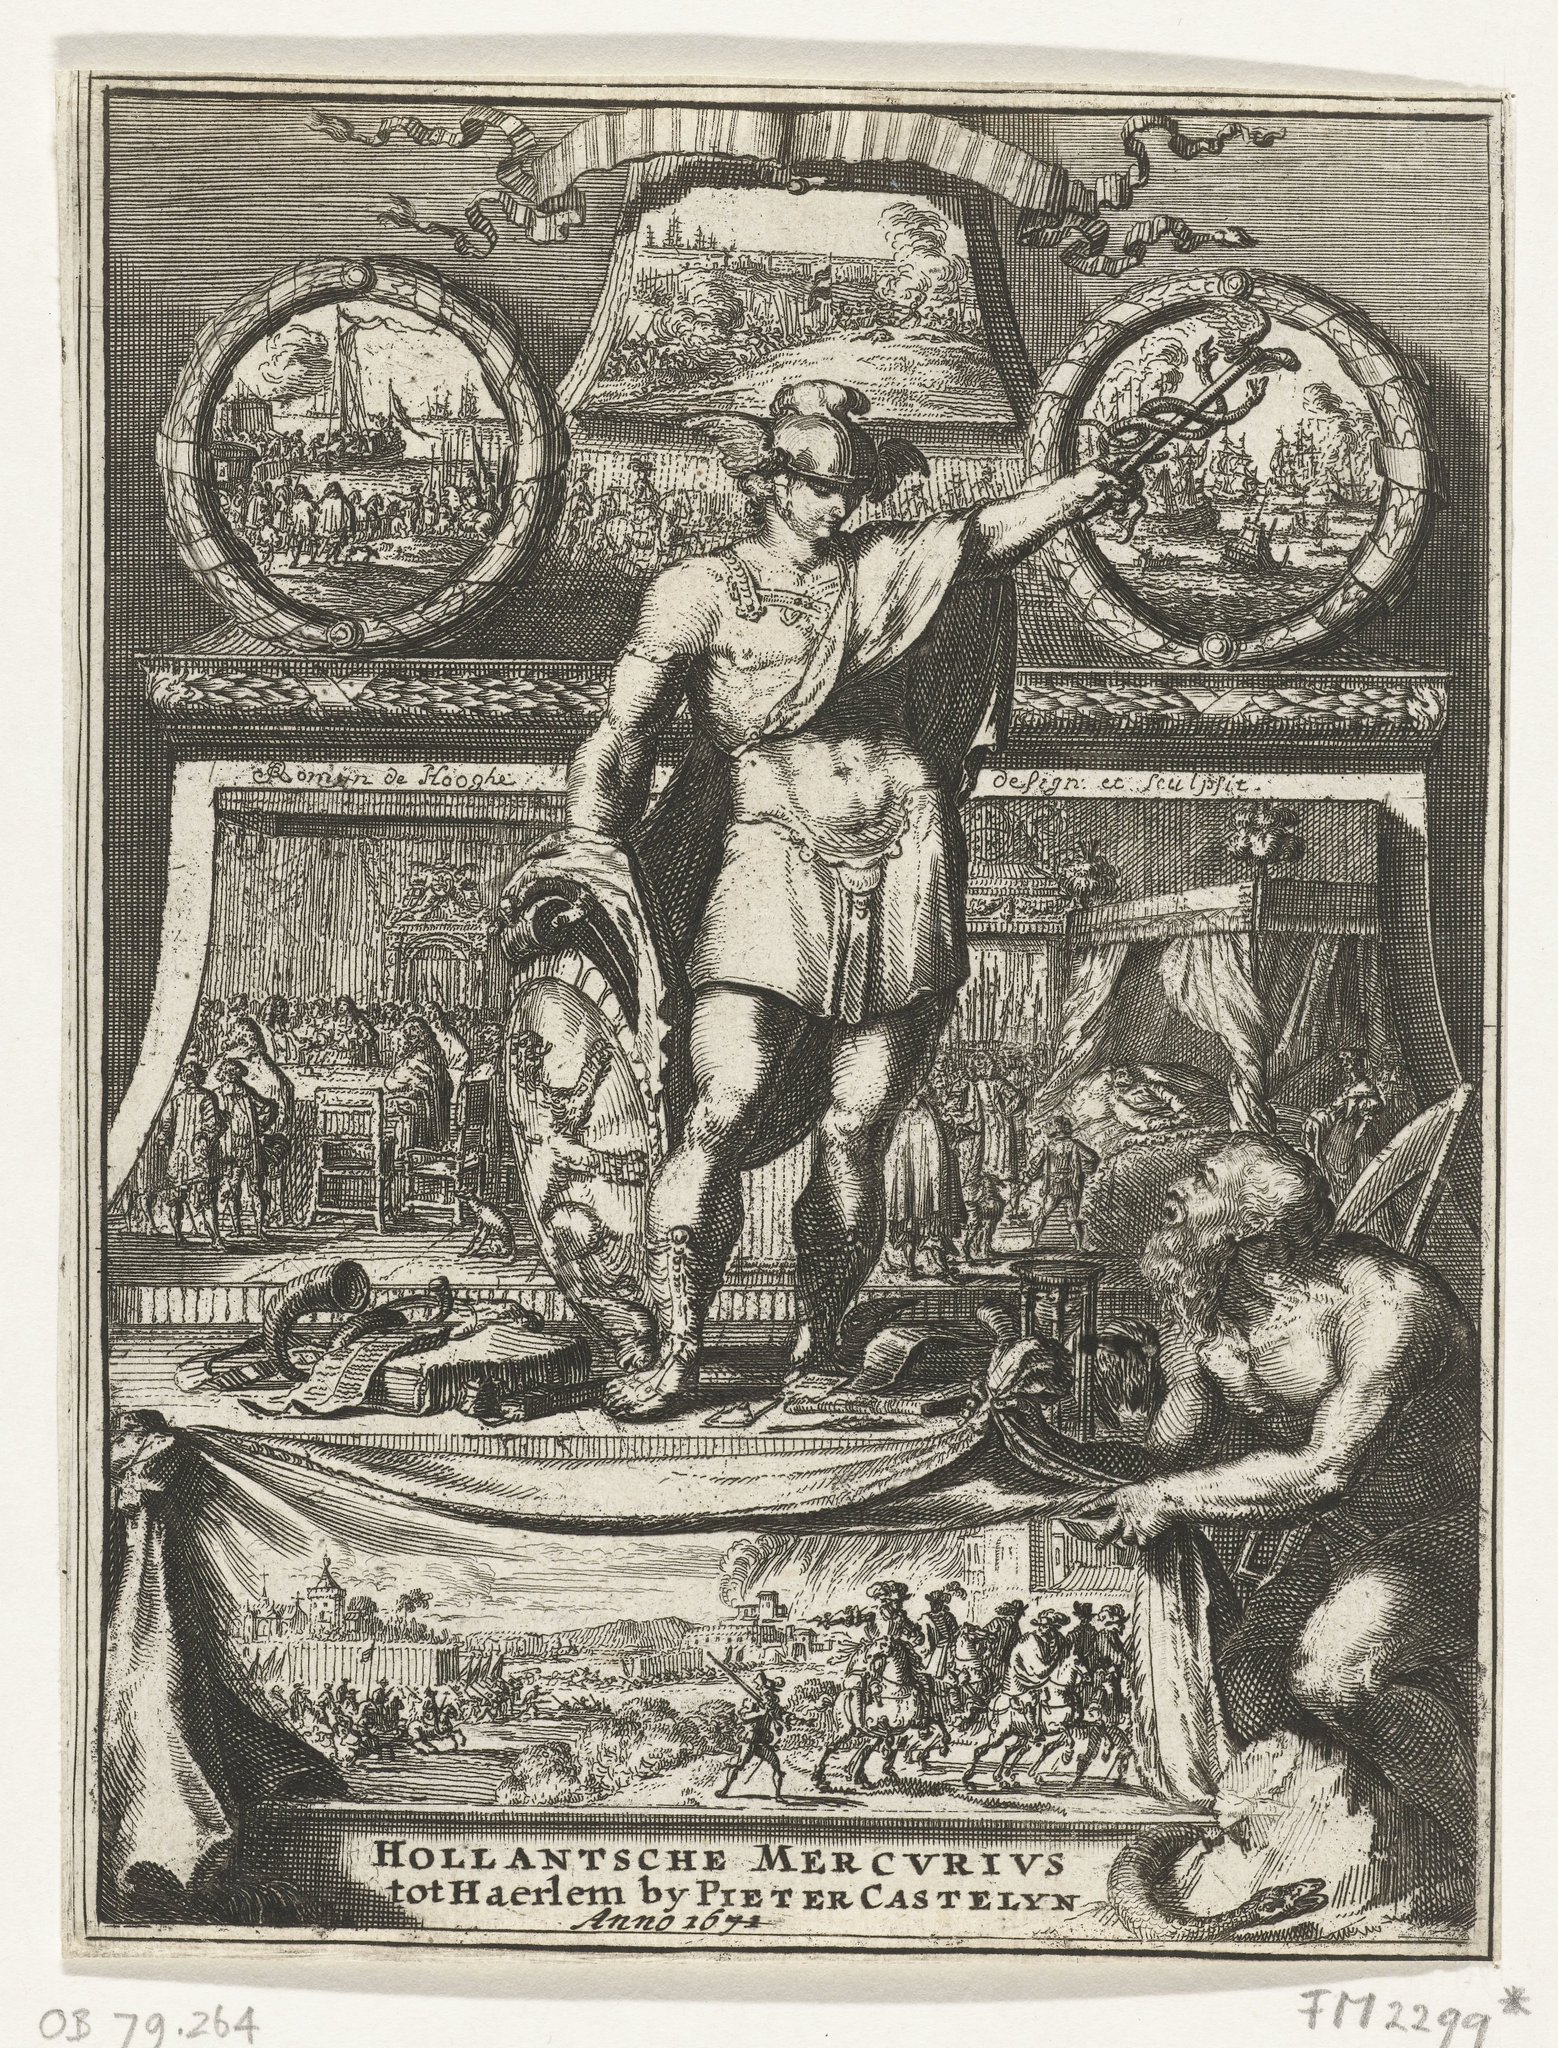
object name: print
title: Titelpagina voor de Hollandsche Mercurius voor het jaar 1671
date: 1672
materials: paper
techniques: etching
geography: haarlem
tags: specific aspects, allegorical aspects of mercury; mercury as patron, father time, man with wings and scythe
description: Titelpagina voor de Hollandsche Mercurius voor het jaar 1671. Mercurius staande op een verhoging met het wapen van Holland, rechts Vader Tijd, hieromheen verschillende kleine scènes van historische gebeurtenissen.